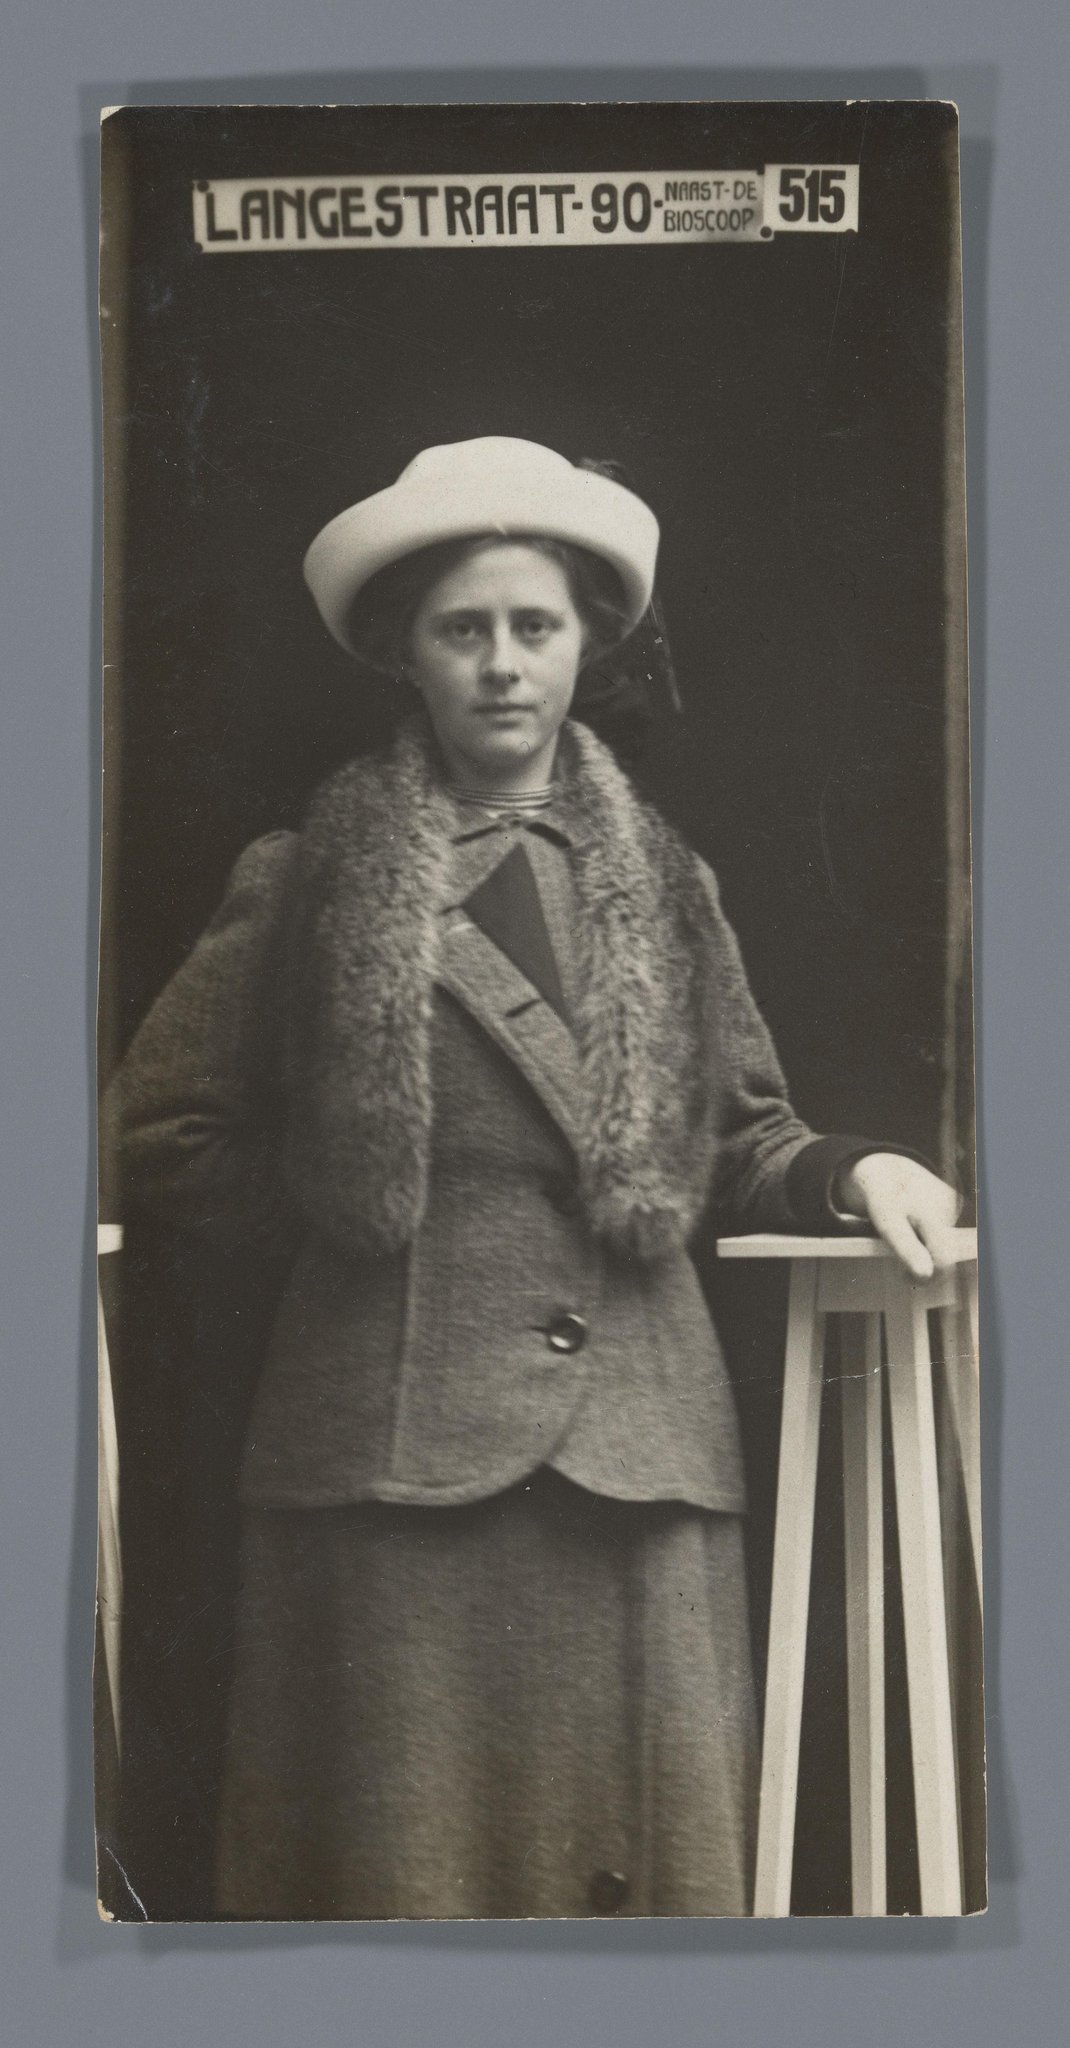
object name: snapshot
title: Rapid photographs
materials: photographic support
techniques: gelatin silver print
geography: alkmaar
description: Between 1912 and 1930, anyone could have their portrait taken at the many so-called rapid photography studios in the shopping streets of mainly (medium) large-size European cities. As if on an assembly line, the youngest clerk shot the photographs with a special camera and in artificial light and developed them. Later in the day, the customer collected a sheet with 12 portrait photos for 25 cents. This form of photographic mass production gave rise to a fascinating tableau of boys, girls, men and women not previously seen in photographs; candid and informal. There were at least 150 quick-photo studios, from Alkmaar to Zutphen. Many called themselves ‘American,’ mistakenly as it turns out because hardly any examples from that country have been found.